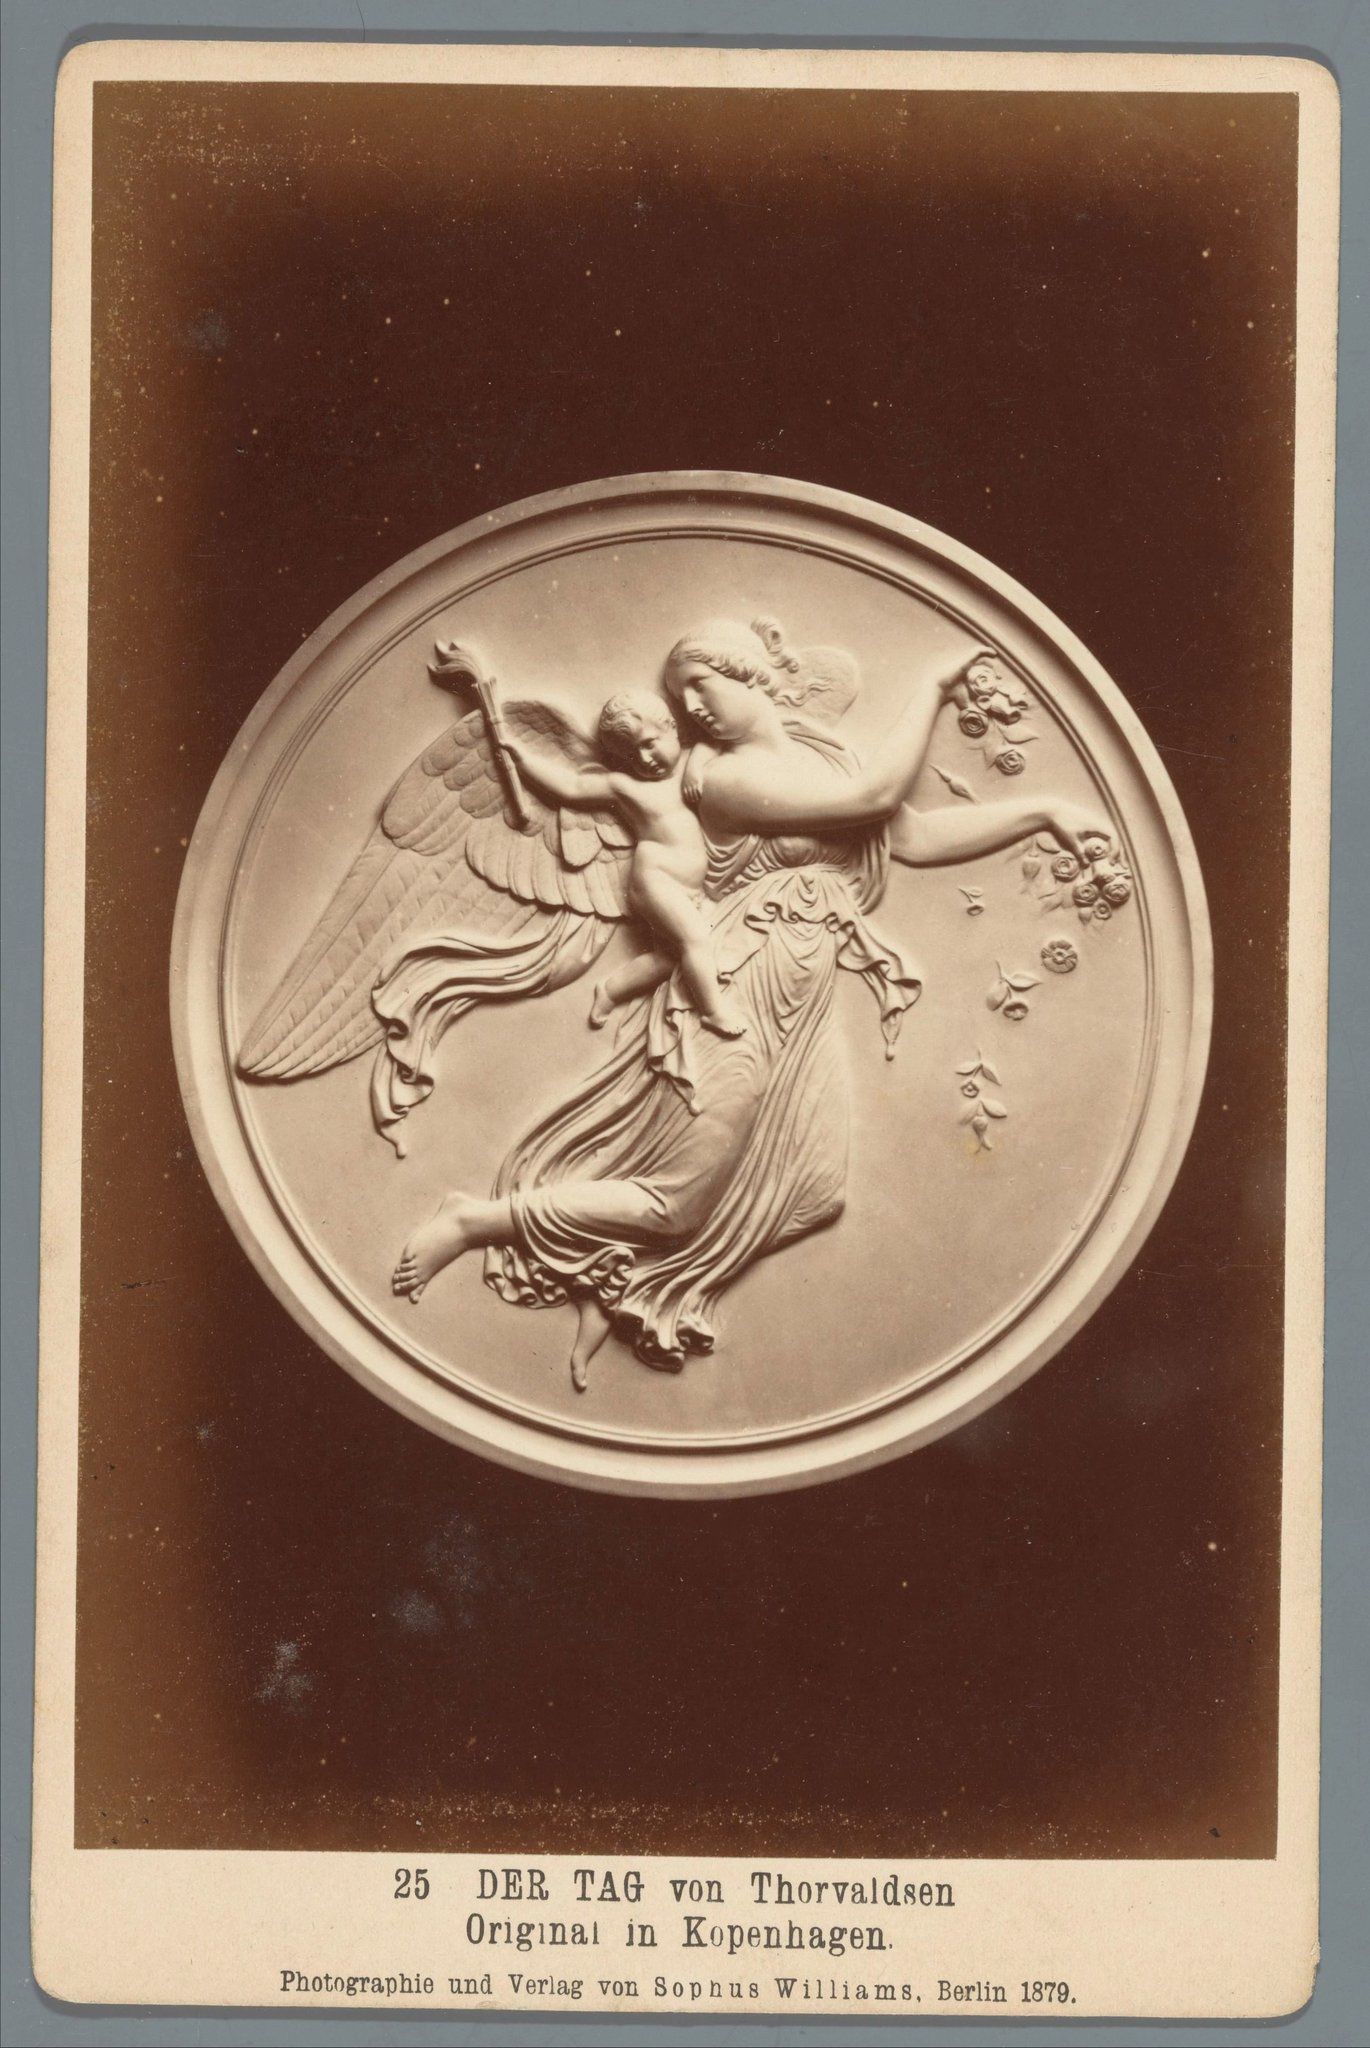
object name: cabinet photograph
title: Reliëf, voorstellende een personificatie van de dag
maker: sophus williams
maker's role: publisher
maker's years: 1835-1900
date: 1879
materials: cardboard, photographic support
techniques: albumen print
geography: berlin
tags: day of 24 hours, natural day, sculpture (+ relief ~ sculpture)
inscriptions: number: ‘25’